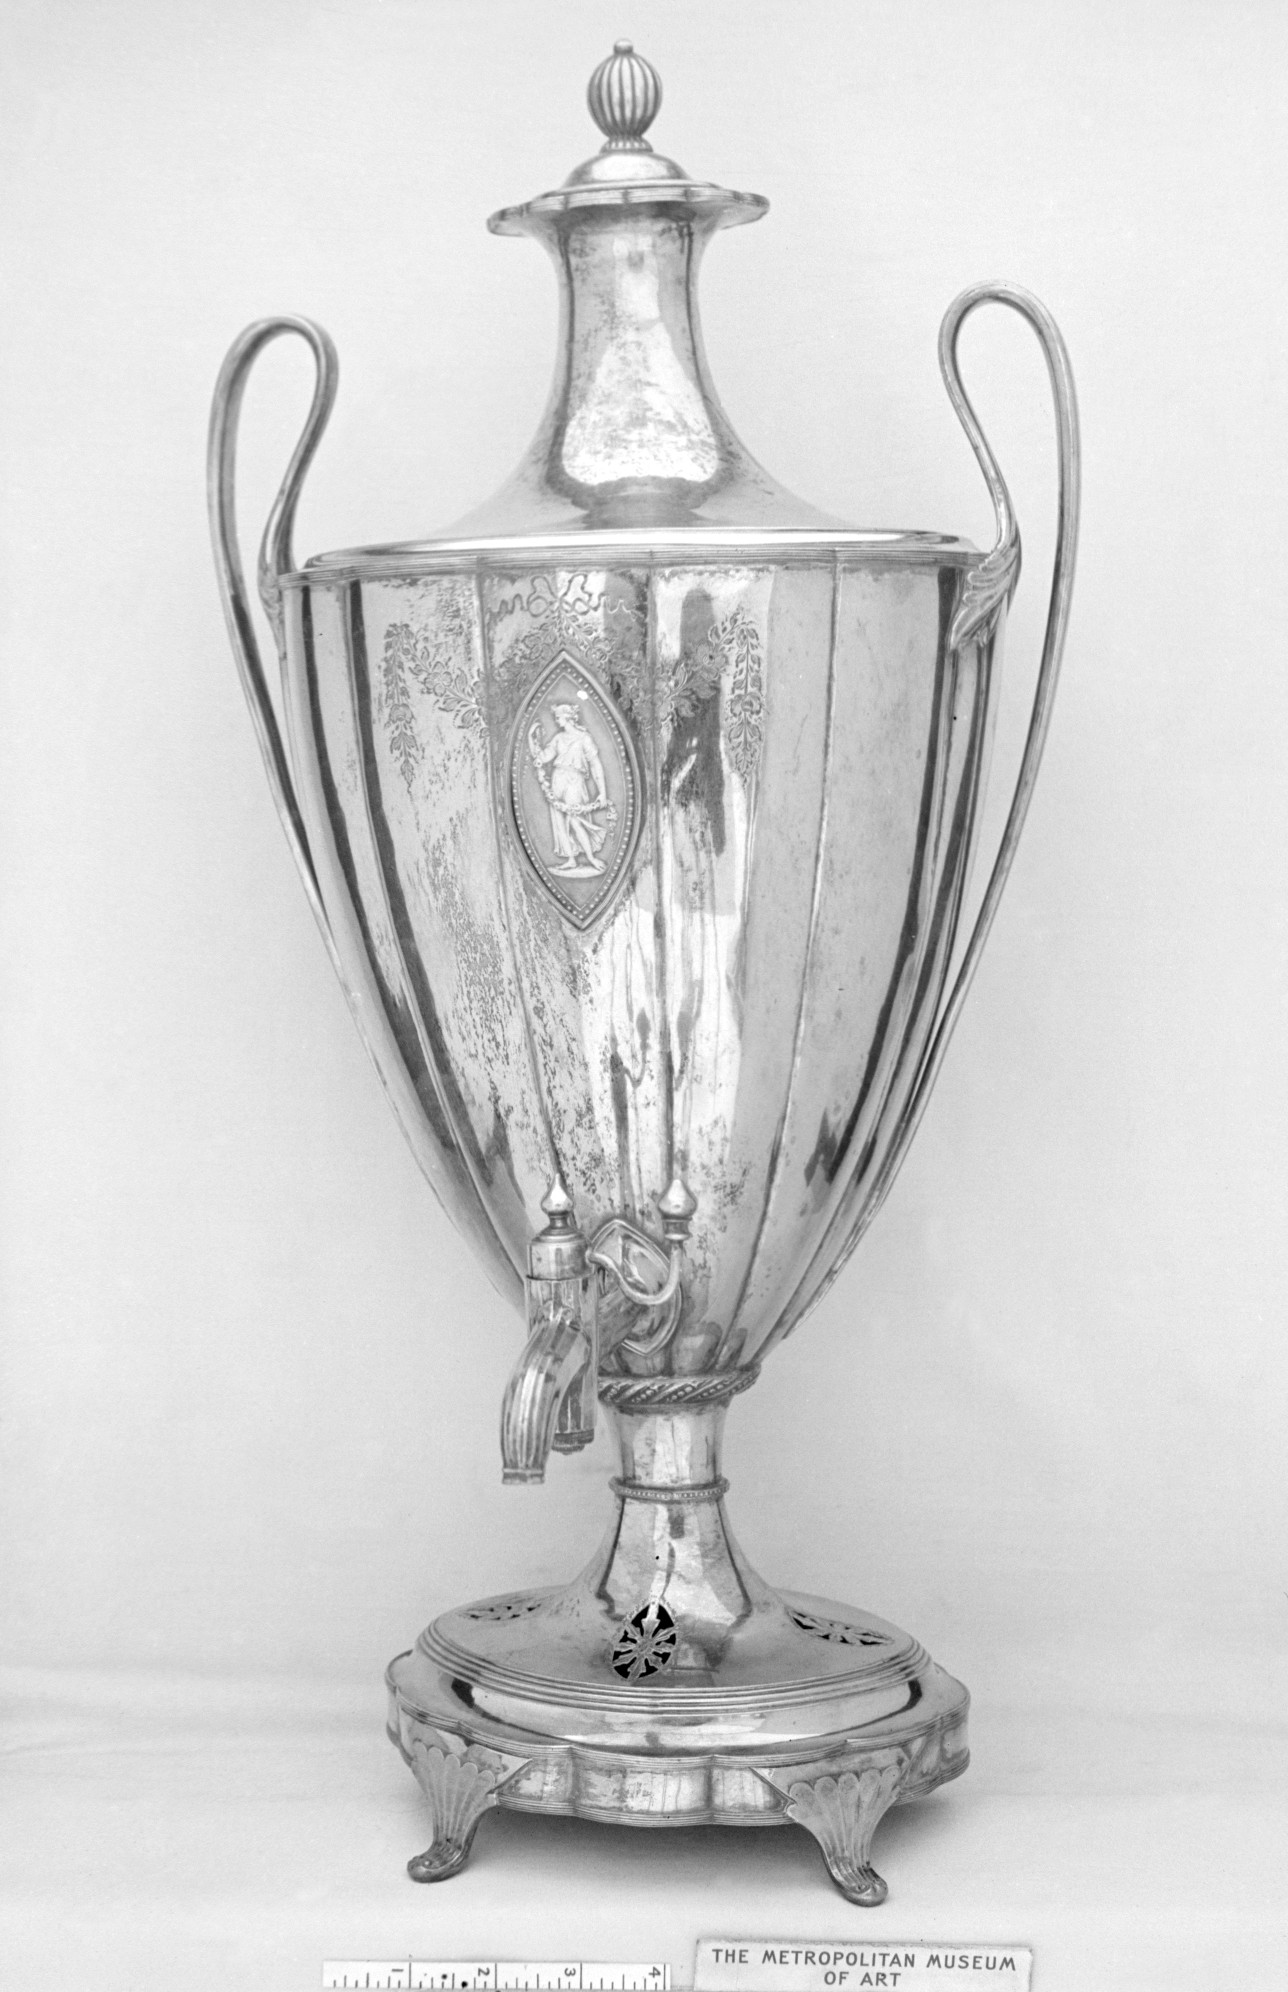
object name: tea urn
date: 1785-1790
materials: gilt, metal